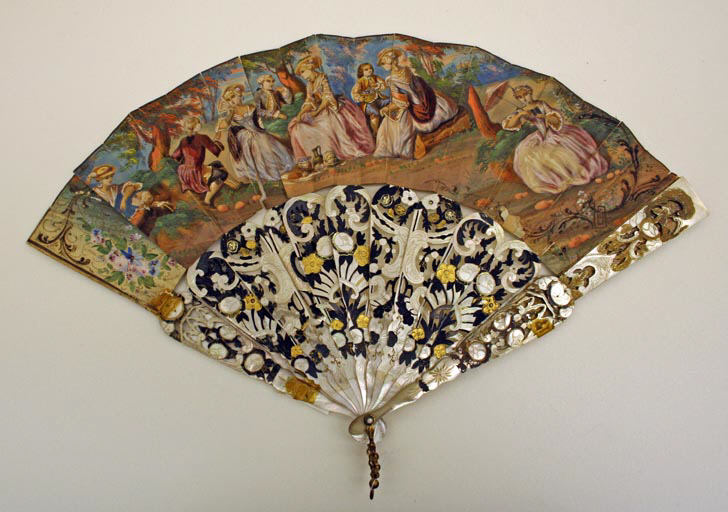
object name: fan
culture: french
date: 1834-1866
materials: mother of pearl, paper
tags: men,women